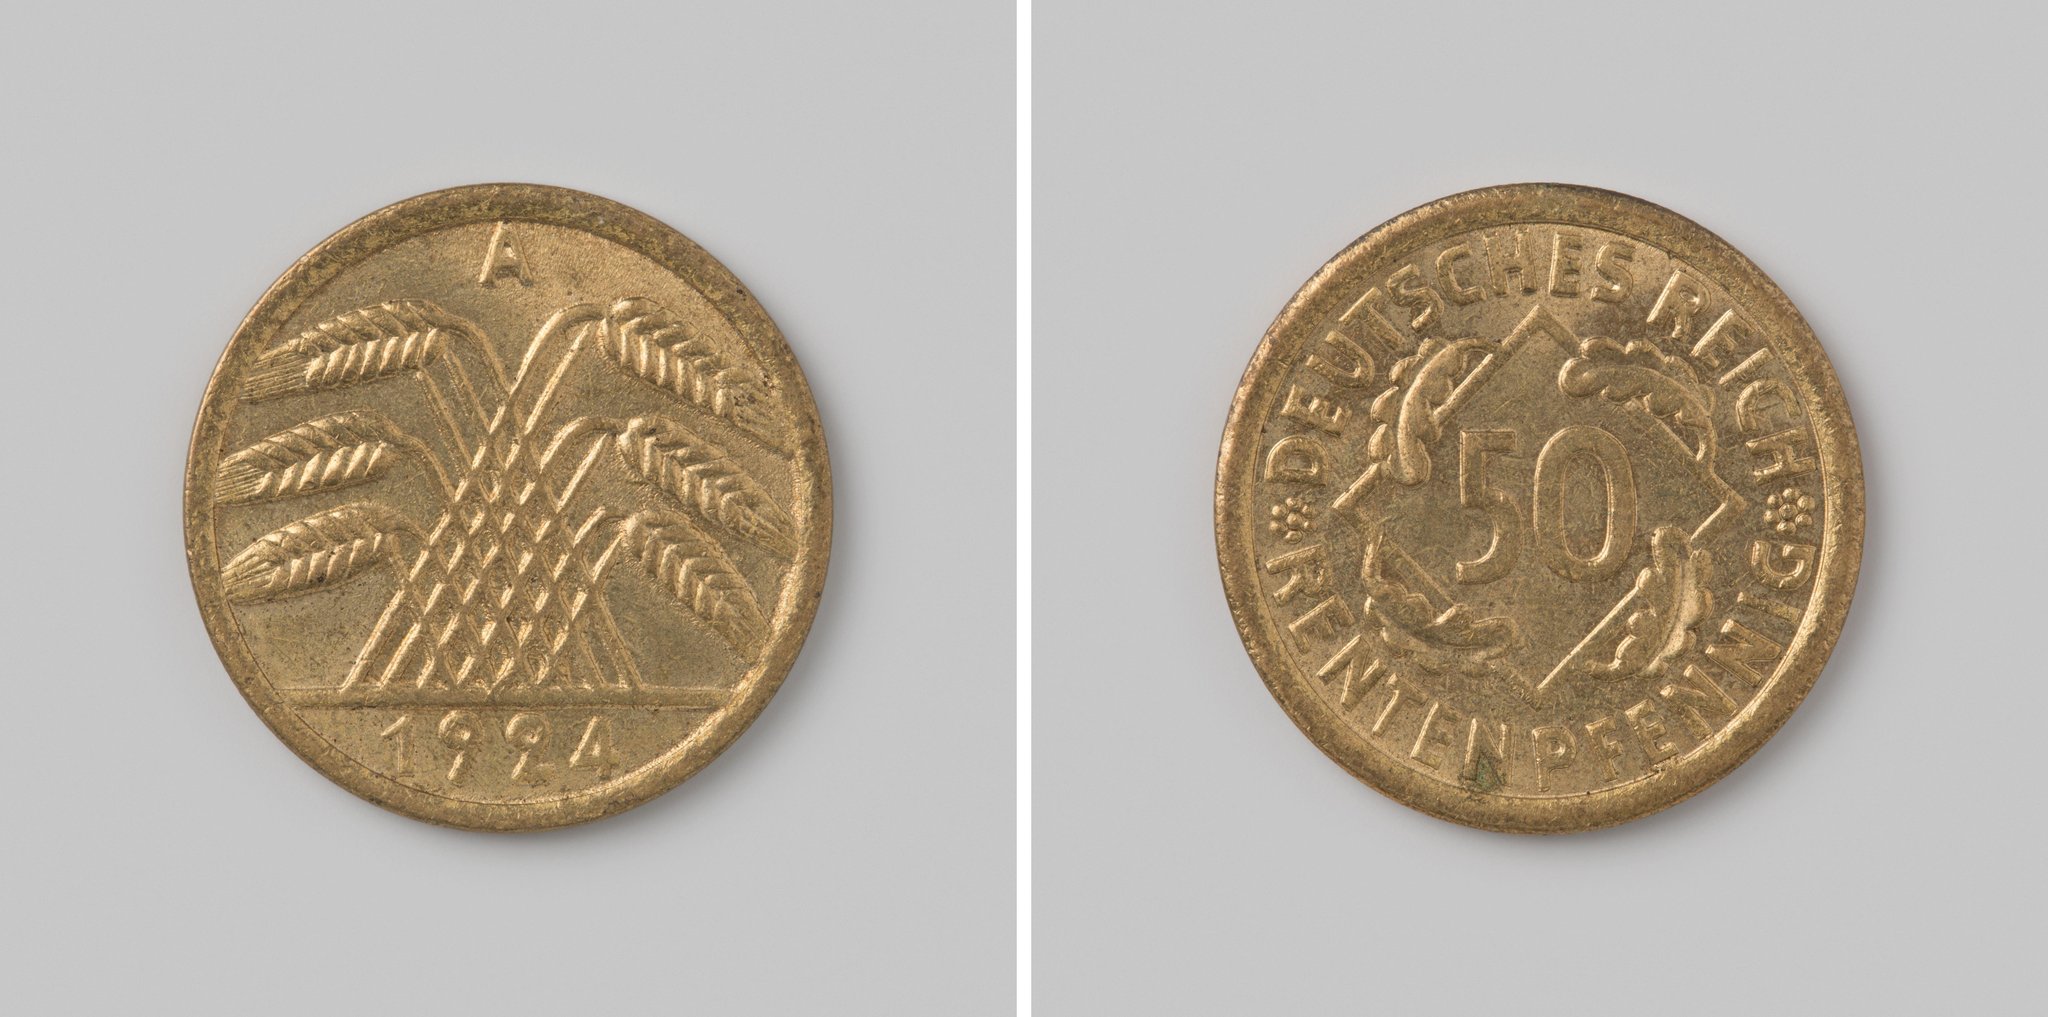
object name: coin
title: Duitsland, 50 Rentenpfennig, 1924 A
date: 1924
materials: bronze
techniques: striking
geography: berlin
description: Aluminium-bronzen munt. Voorzijde: zes, op symmetrische wijze in elkaar gevlochten korenaren. Jaartal in afsnede. Letter A bovenaan. Keerzijde: in versierde ruit waarde-aanduiding 40, waaronder rentenpfennig. Kartelrand.